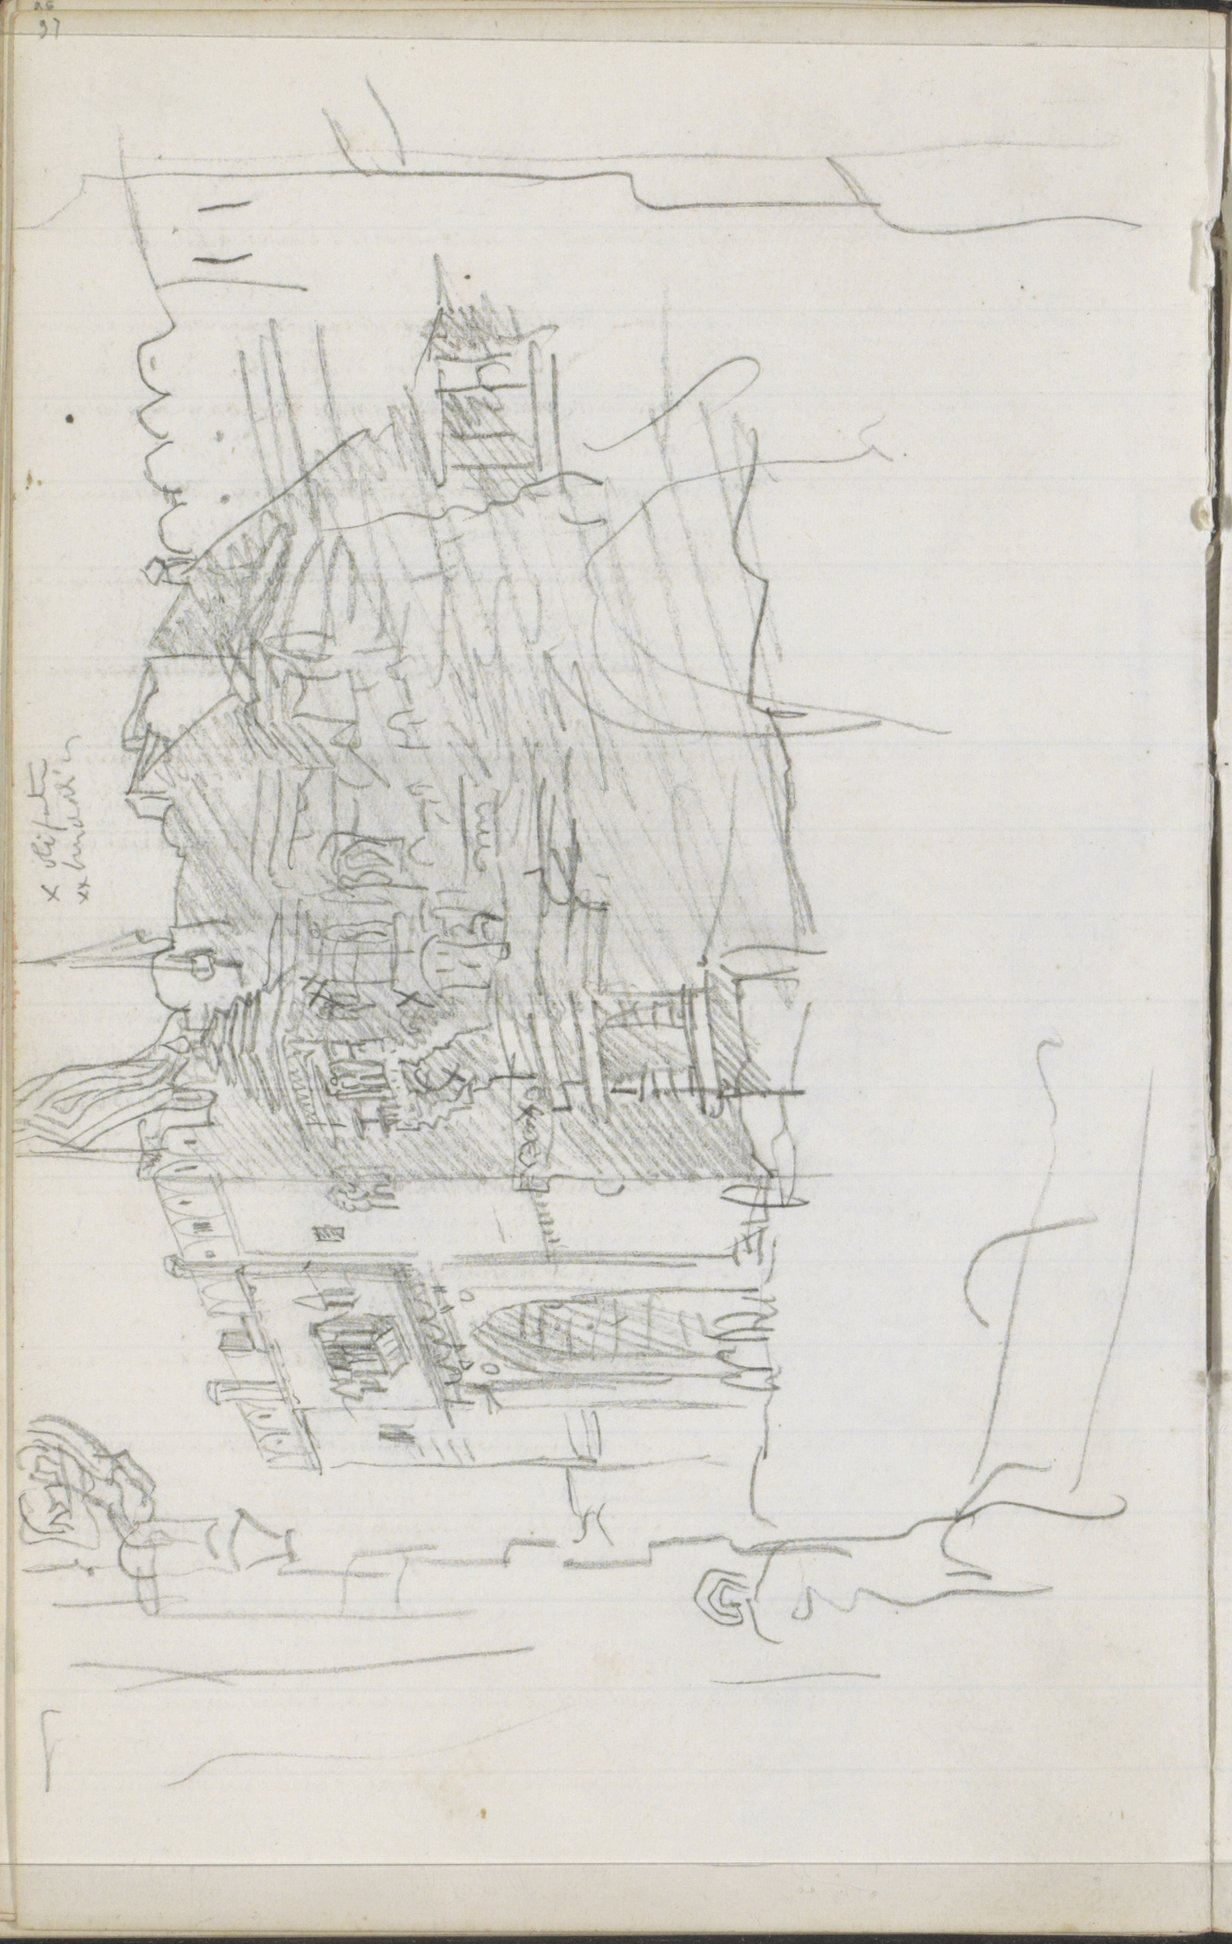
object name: sketchbook leaf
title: Muur en poort van het Dabhoi fort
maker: marius bauer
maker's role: draughtsman, print maker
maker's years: 1867-1932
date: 1897-1898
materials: pencil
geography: gujarat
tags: flags flown from a mast, arch, archivolt ~ architecture, walls ~ fortified city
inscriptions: annotation: ‘x olifant/ xx [...]’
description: Pagina 97 uit een schetsboek met 62 bladen.